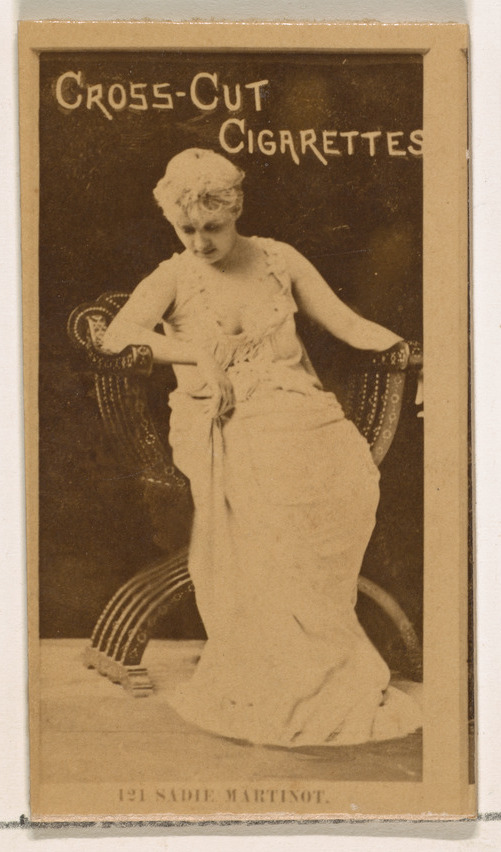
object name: print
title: Card Number 121, Miss Sadie Martinot, from the Actors and Actresses series (N145-2) issued by Duke Sons & Co. to promote Cross Cut Cigarettes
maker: w. duke, sons & co.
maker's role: publisher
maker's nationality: american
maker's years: 1870-1920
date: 1880-1889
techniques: albumen silver print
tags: portraits,women,actresses